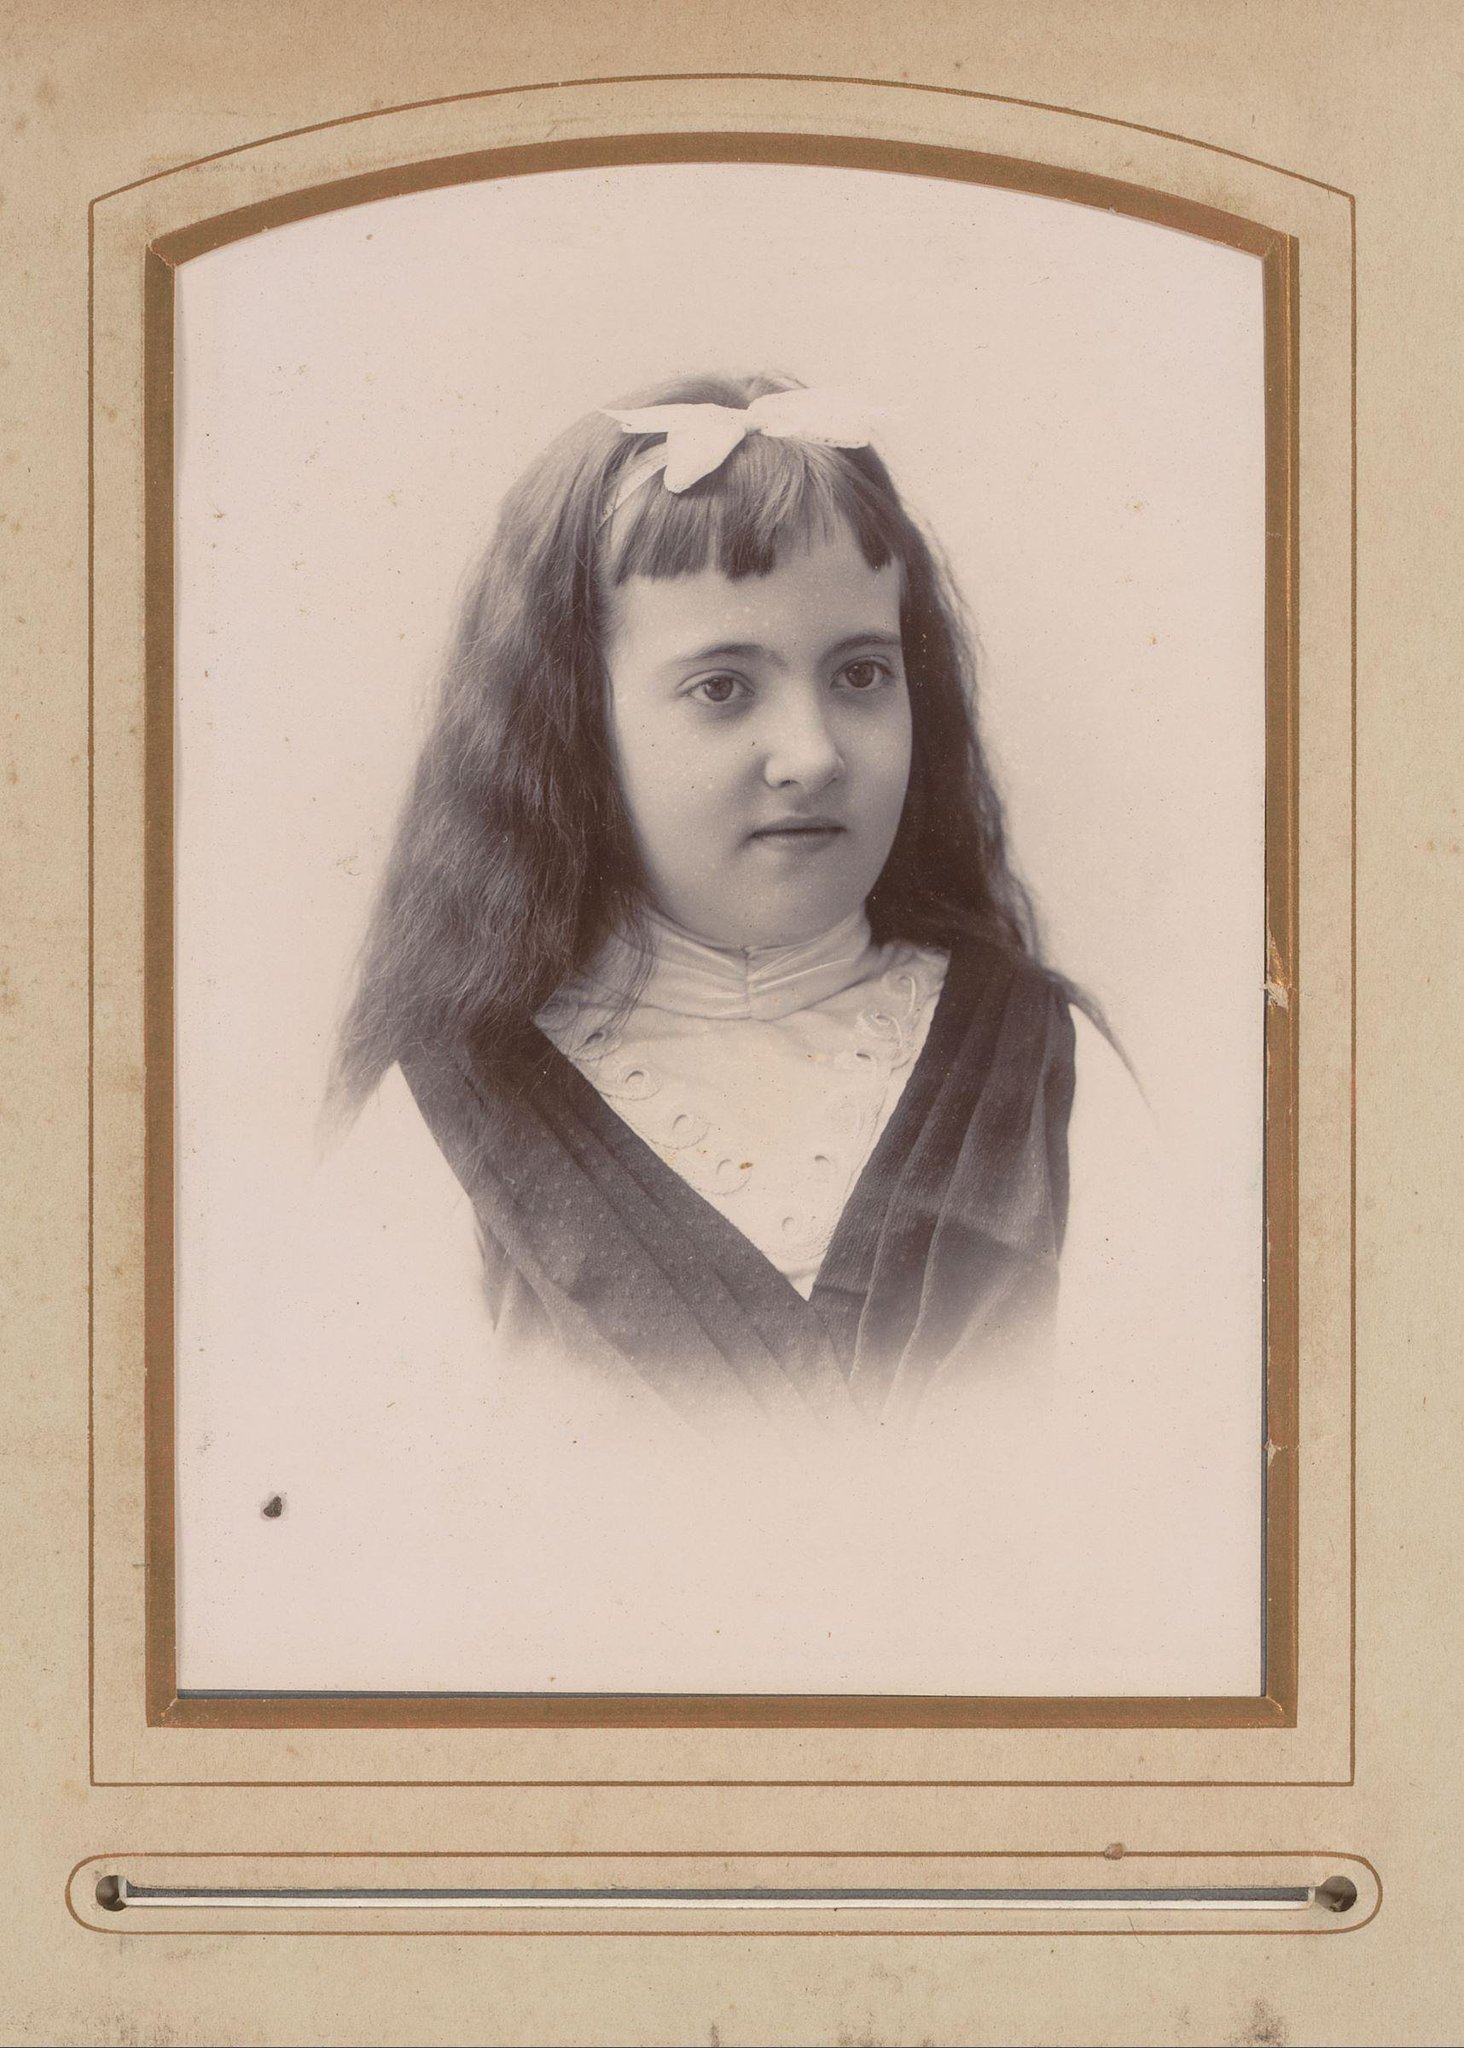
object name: cabinet photograph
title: Portret van een meisje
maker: onnes kurkdjian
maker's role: fotograaf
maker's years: 1851-1903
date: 1890-1903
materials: cardboard, photographic support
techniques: gelatin silver print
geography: surabaya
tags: historical persons - bb - woman, girl (child between toddler and youth)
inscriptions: inscription: ‘O. Kurkdjian/ HOF-PHOTOGRAAF/ van/ H.M.DE KONINGIN./ Soerabaya.’